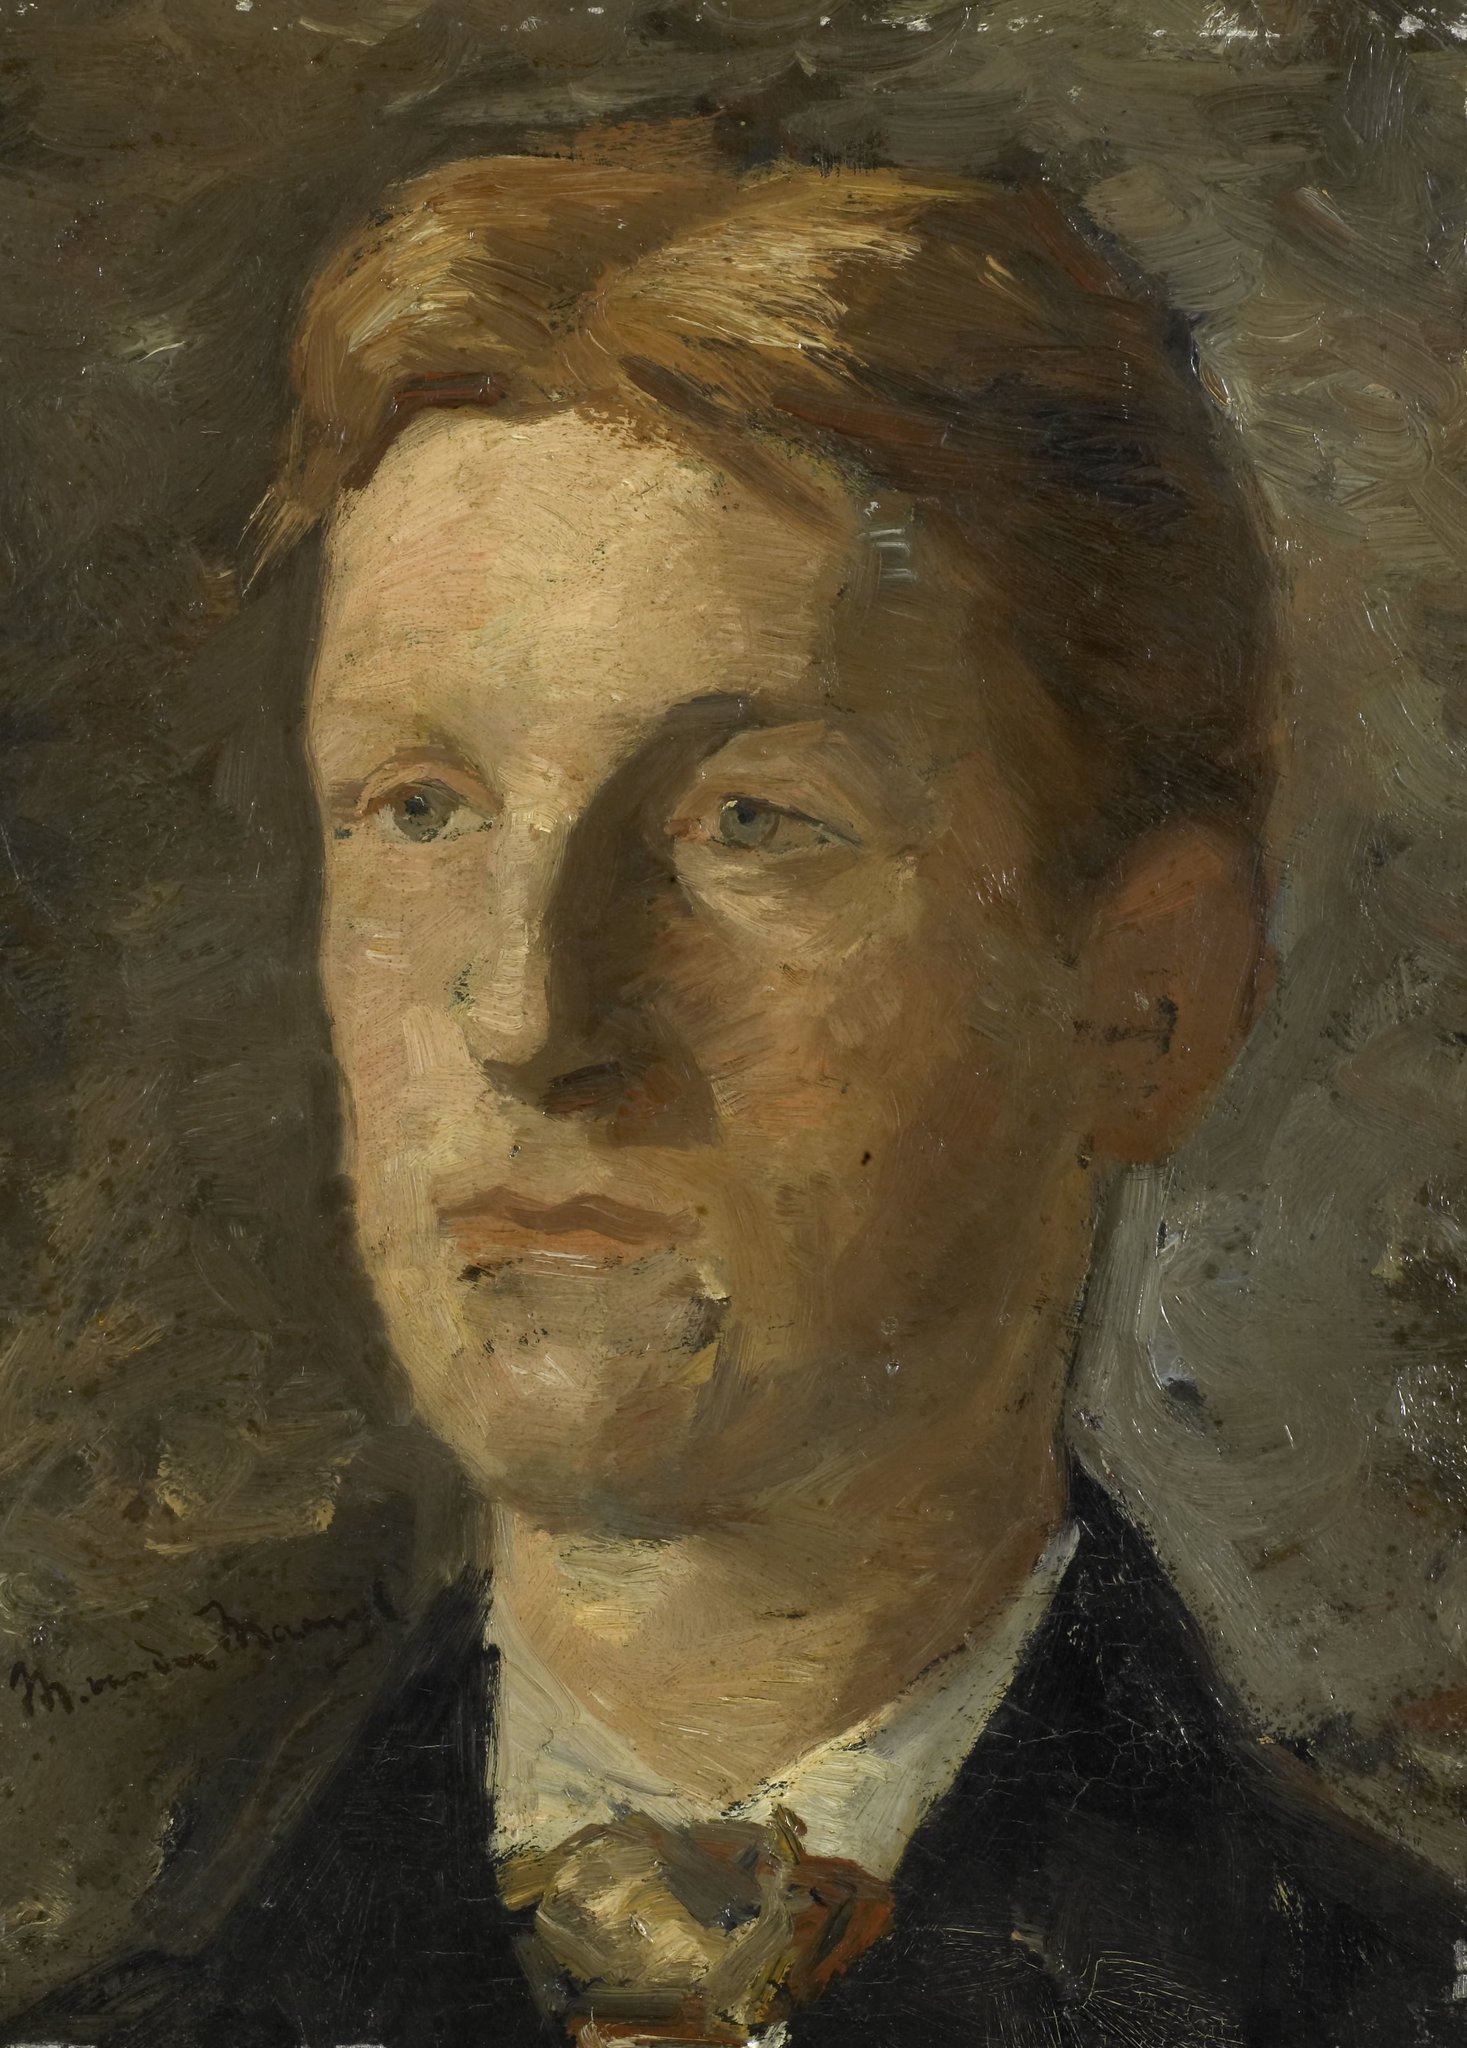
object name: painting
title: Adriaan Pit (1860-1944). Directeur van het Nederlands Museum voor Geschiedenis en Kunst te Amsterdam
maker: marinus van der maarel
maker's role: draughtsman, painter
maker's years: 1857-1921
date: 1880-1921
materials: canvas, oil, panel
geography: netherlands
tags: the hague, nijmegen, print maker, adriaan pit, museum personnel, historical persons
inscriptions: signature: ‘M. van der Maarel’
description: Portret van Adriaan Pit. Van 1898 tot 1918 directeur van het Nederlands Museum voor Geschiedenis en Kunst te Amsterdam. Buste, de kop iets naar links gewend.